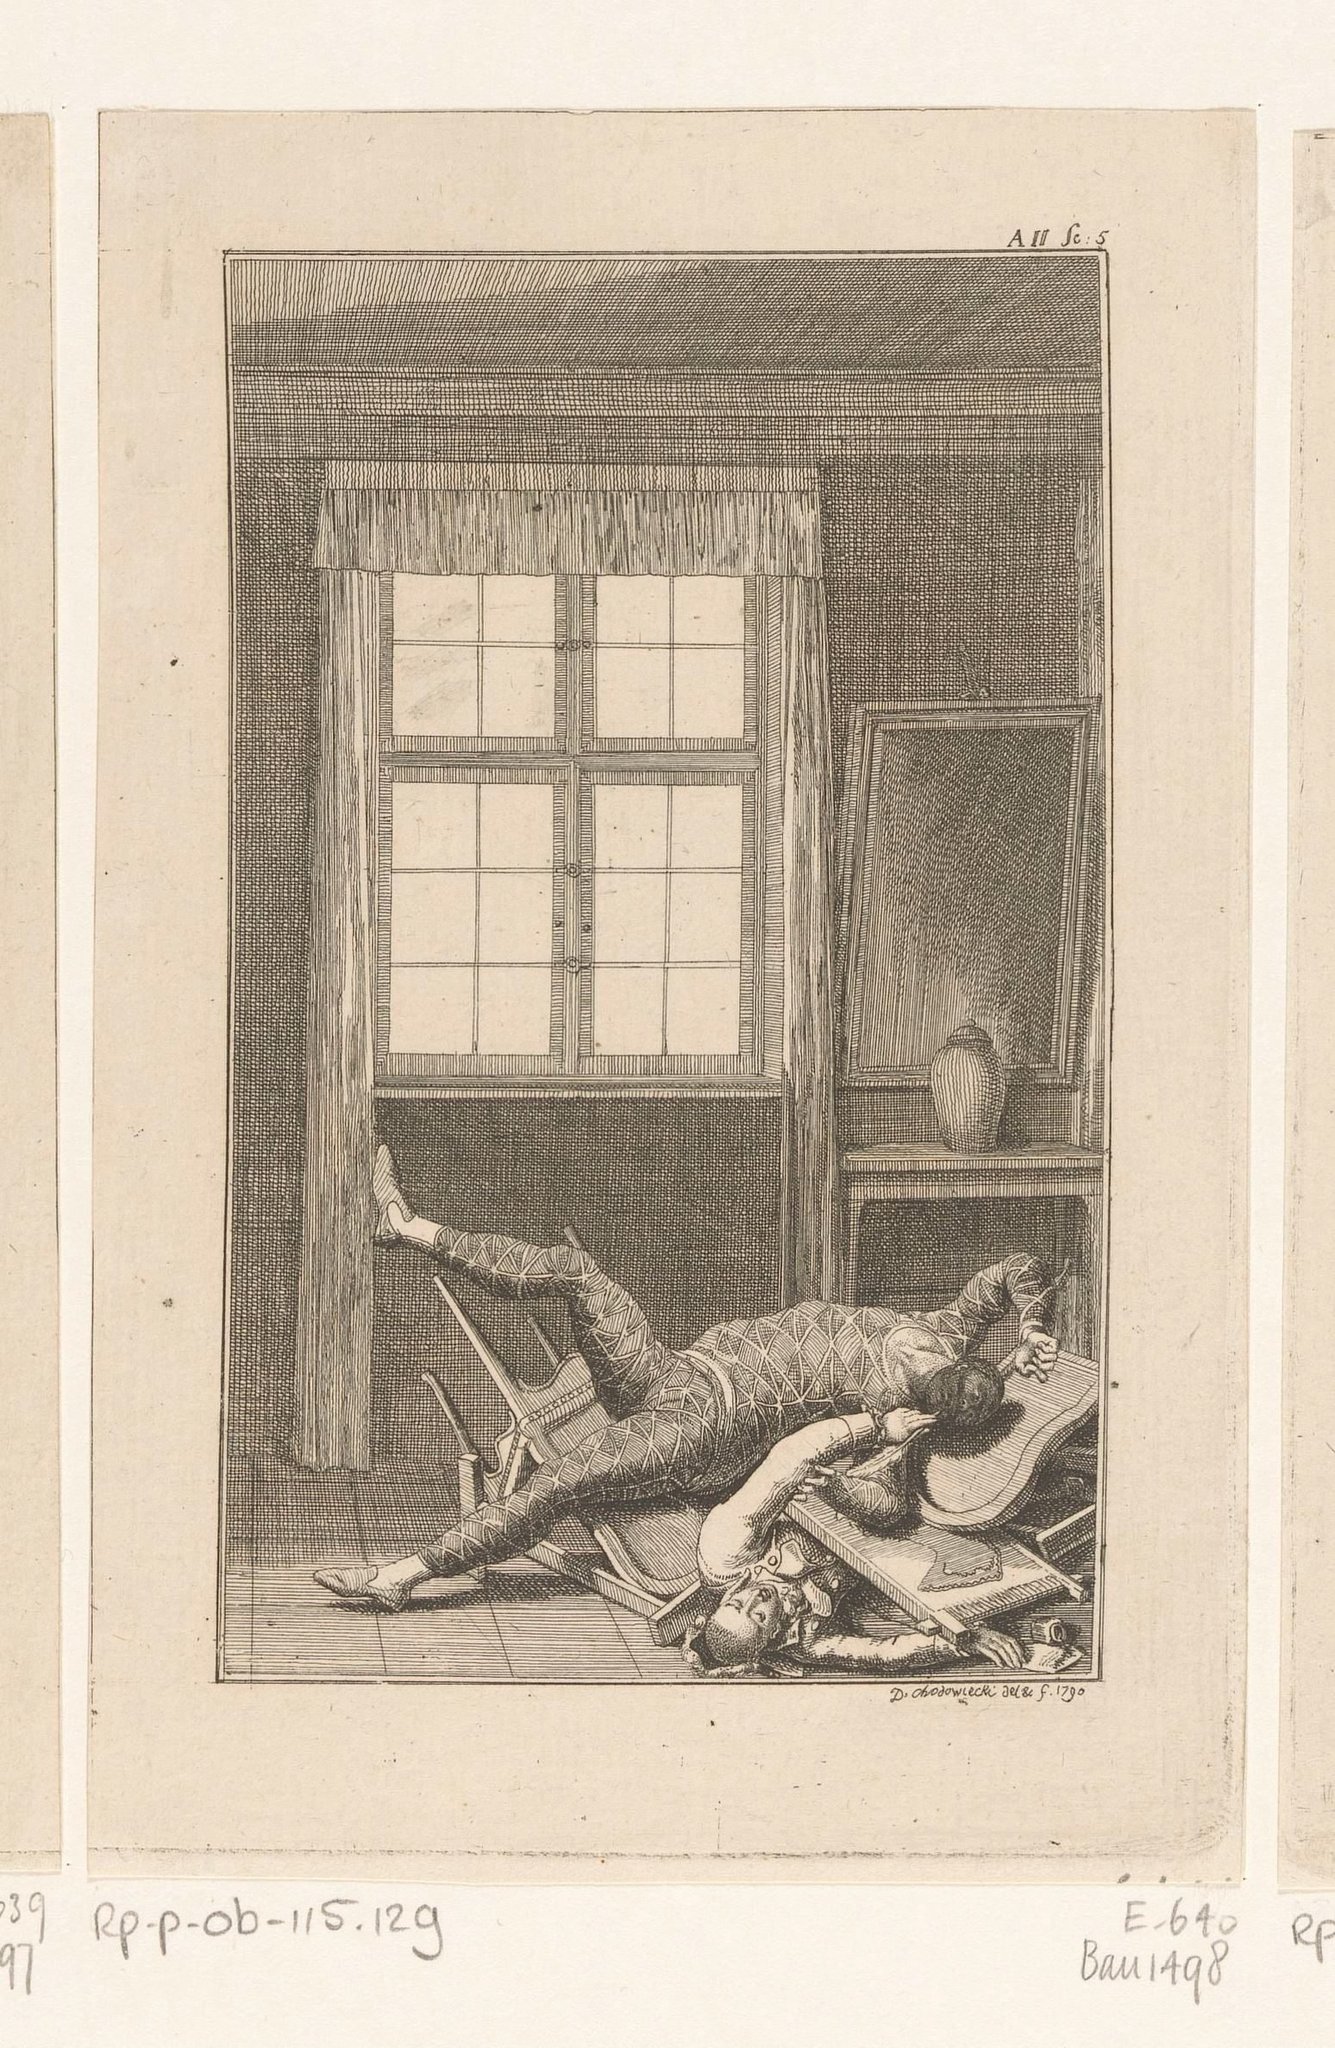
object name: print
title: Harlekijn en zijn toekomstige schoonzoon omgevallen tussen de meubels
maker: daniel nikolaus chodowiecki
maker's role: draughtsman, print maker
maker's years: 1726-1801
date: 1790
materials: paper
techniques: etching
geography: berlin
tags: copenhagen (city), literature, falling, types in 'commedia dell'arte': harlequin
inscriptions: collector's mark: Lugt 2228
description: Prenten gebruikt voor: Ewald, Johannes. Joh. Ewald's samtlige Skrifter. 4 dln. Kopenhagen: s.n., 1781-91.